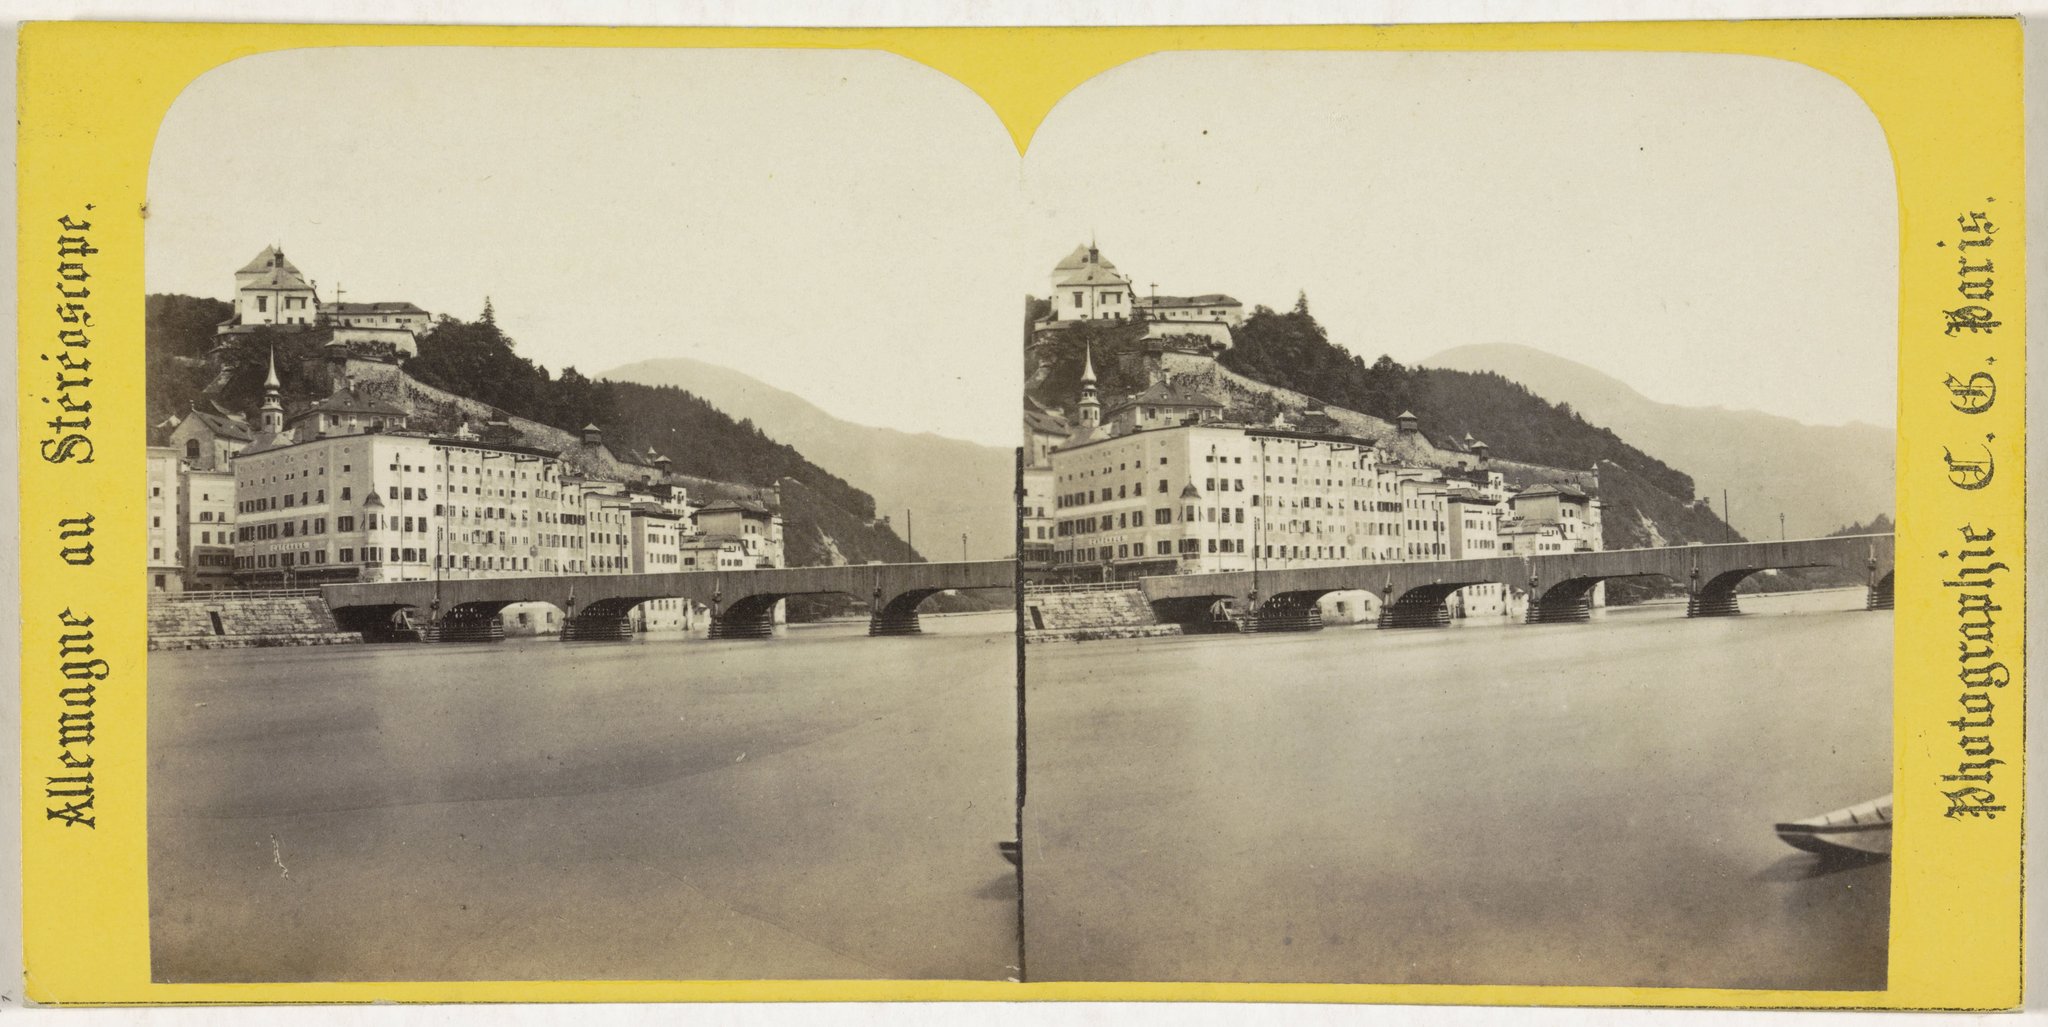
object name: stereograph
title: Allemagne au stéréoscope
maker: charles gaudin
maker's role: publisher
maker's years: 1825-1905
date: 1868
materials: cardboard, paper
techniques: albumen print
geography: salzburg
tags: bridge in city across river, canal, etc.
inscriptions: number: ‘60’, number: ‘60.’